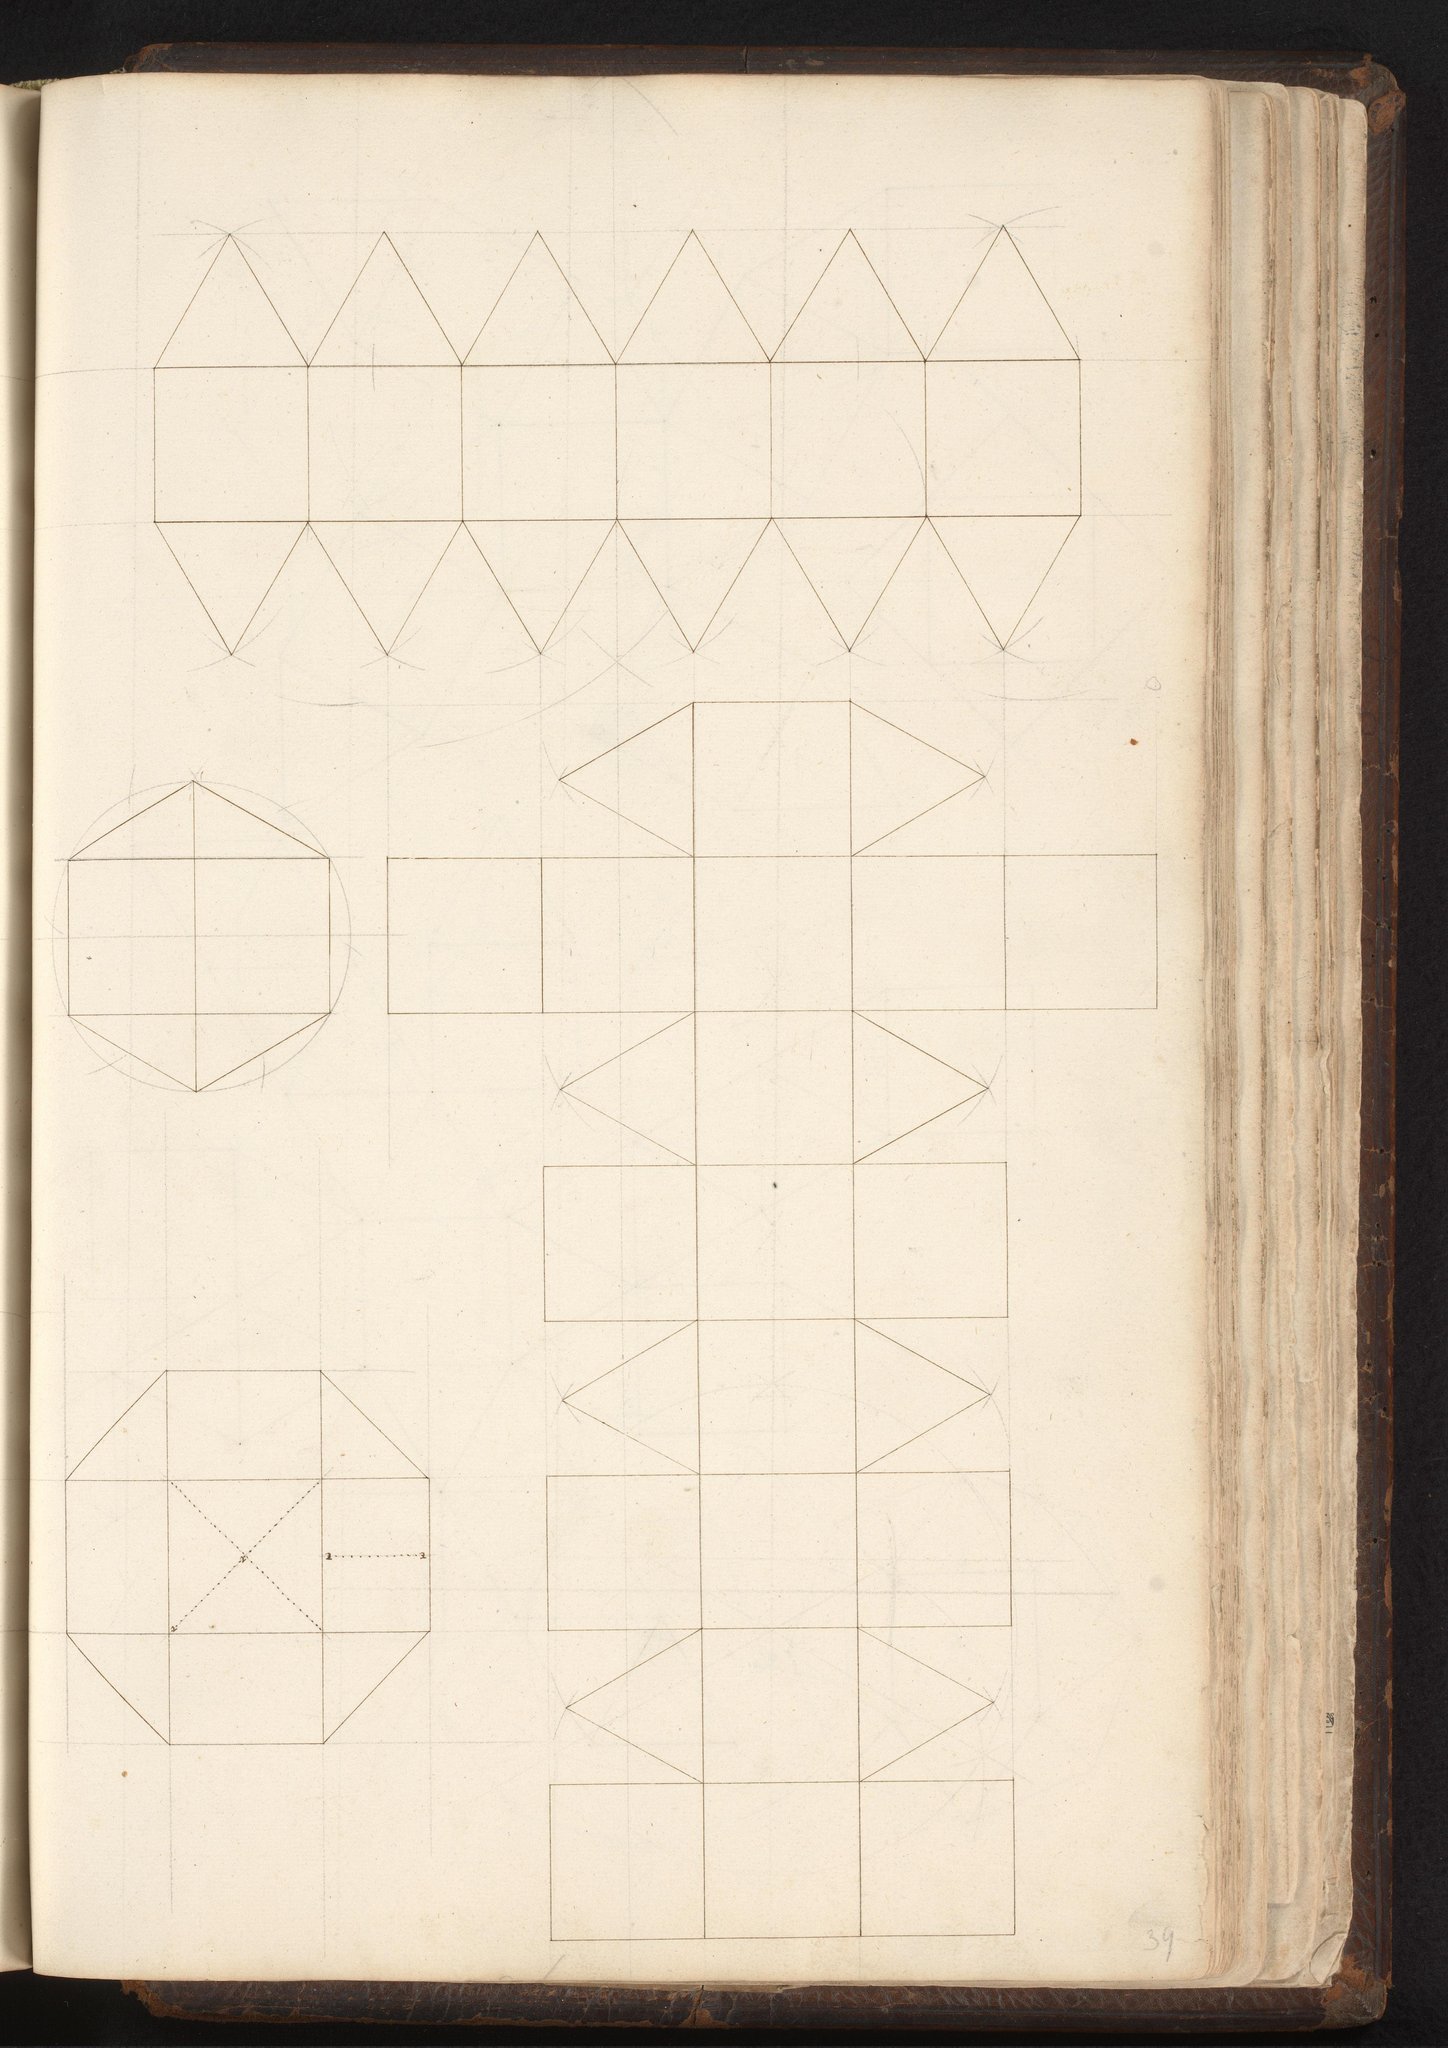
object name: album leaf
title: Geometrische figuren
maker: Anonymous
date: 1650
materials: ink, paper, pencil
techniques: pen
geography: low countries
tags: planimetry, geometry